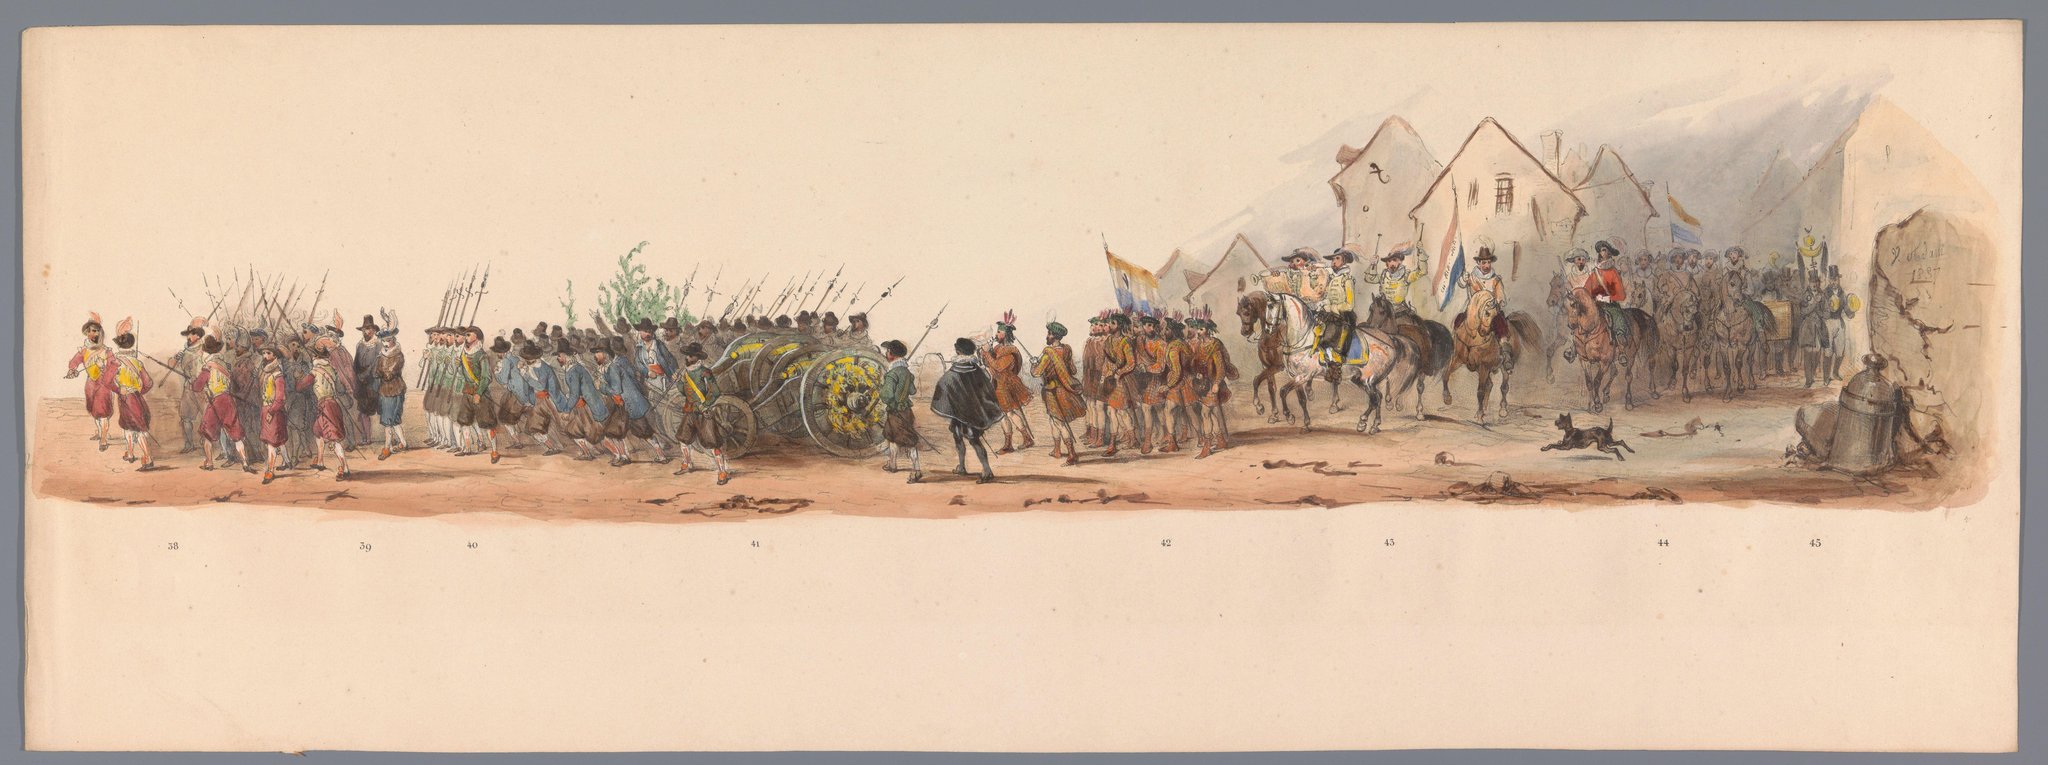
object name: print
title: Optogt des Nederlandschen Legers naar Ostende, den 3 July 1600, daags na de overwinning by Nieuwpoort; volgens de gecostumeerde voorstelling, gegeven door H H Studenten, by gelegenheid van het Tweede Eeuwfeest der Utrechtsche Hoogeschool. den 16 Juny 1836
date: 1837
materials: paper, watercolor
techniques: hand coloring, lithograph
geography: paris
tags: students' pageant, costumes used in pageants, battle of nieuwpoort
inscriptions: date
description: Historische gekostumeerde optocht van de studenten van de Hogeschool van Utrecht op 16 juni 1836, bij de viering van het tweede eeuwfeest van de Utrechtse Hogeschool. De optocht verbeeldt de intocht van het Staatse leger in Oostende op 3 juli 1600, daags na de overwinning in de Slag bij Nieuwpoort. Tiende en laatste plaat in een serie van tien ongenummerde platen, met de groepen genummerd 34-37.